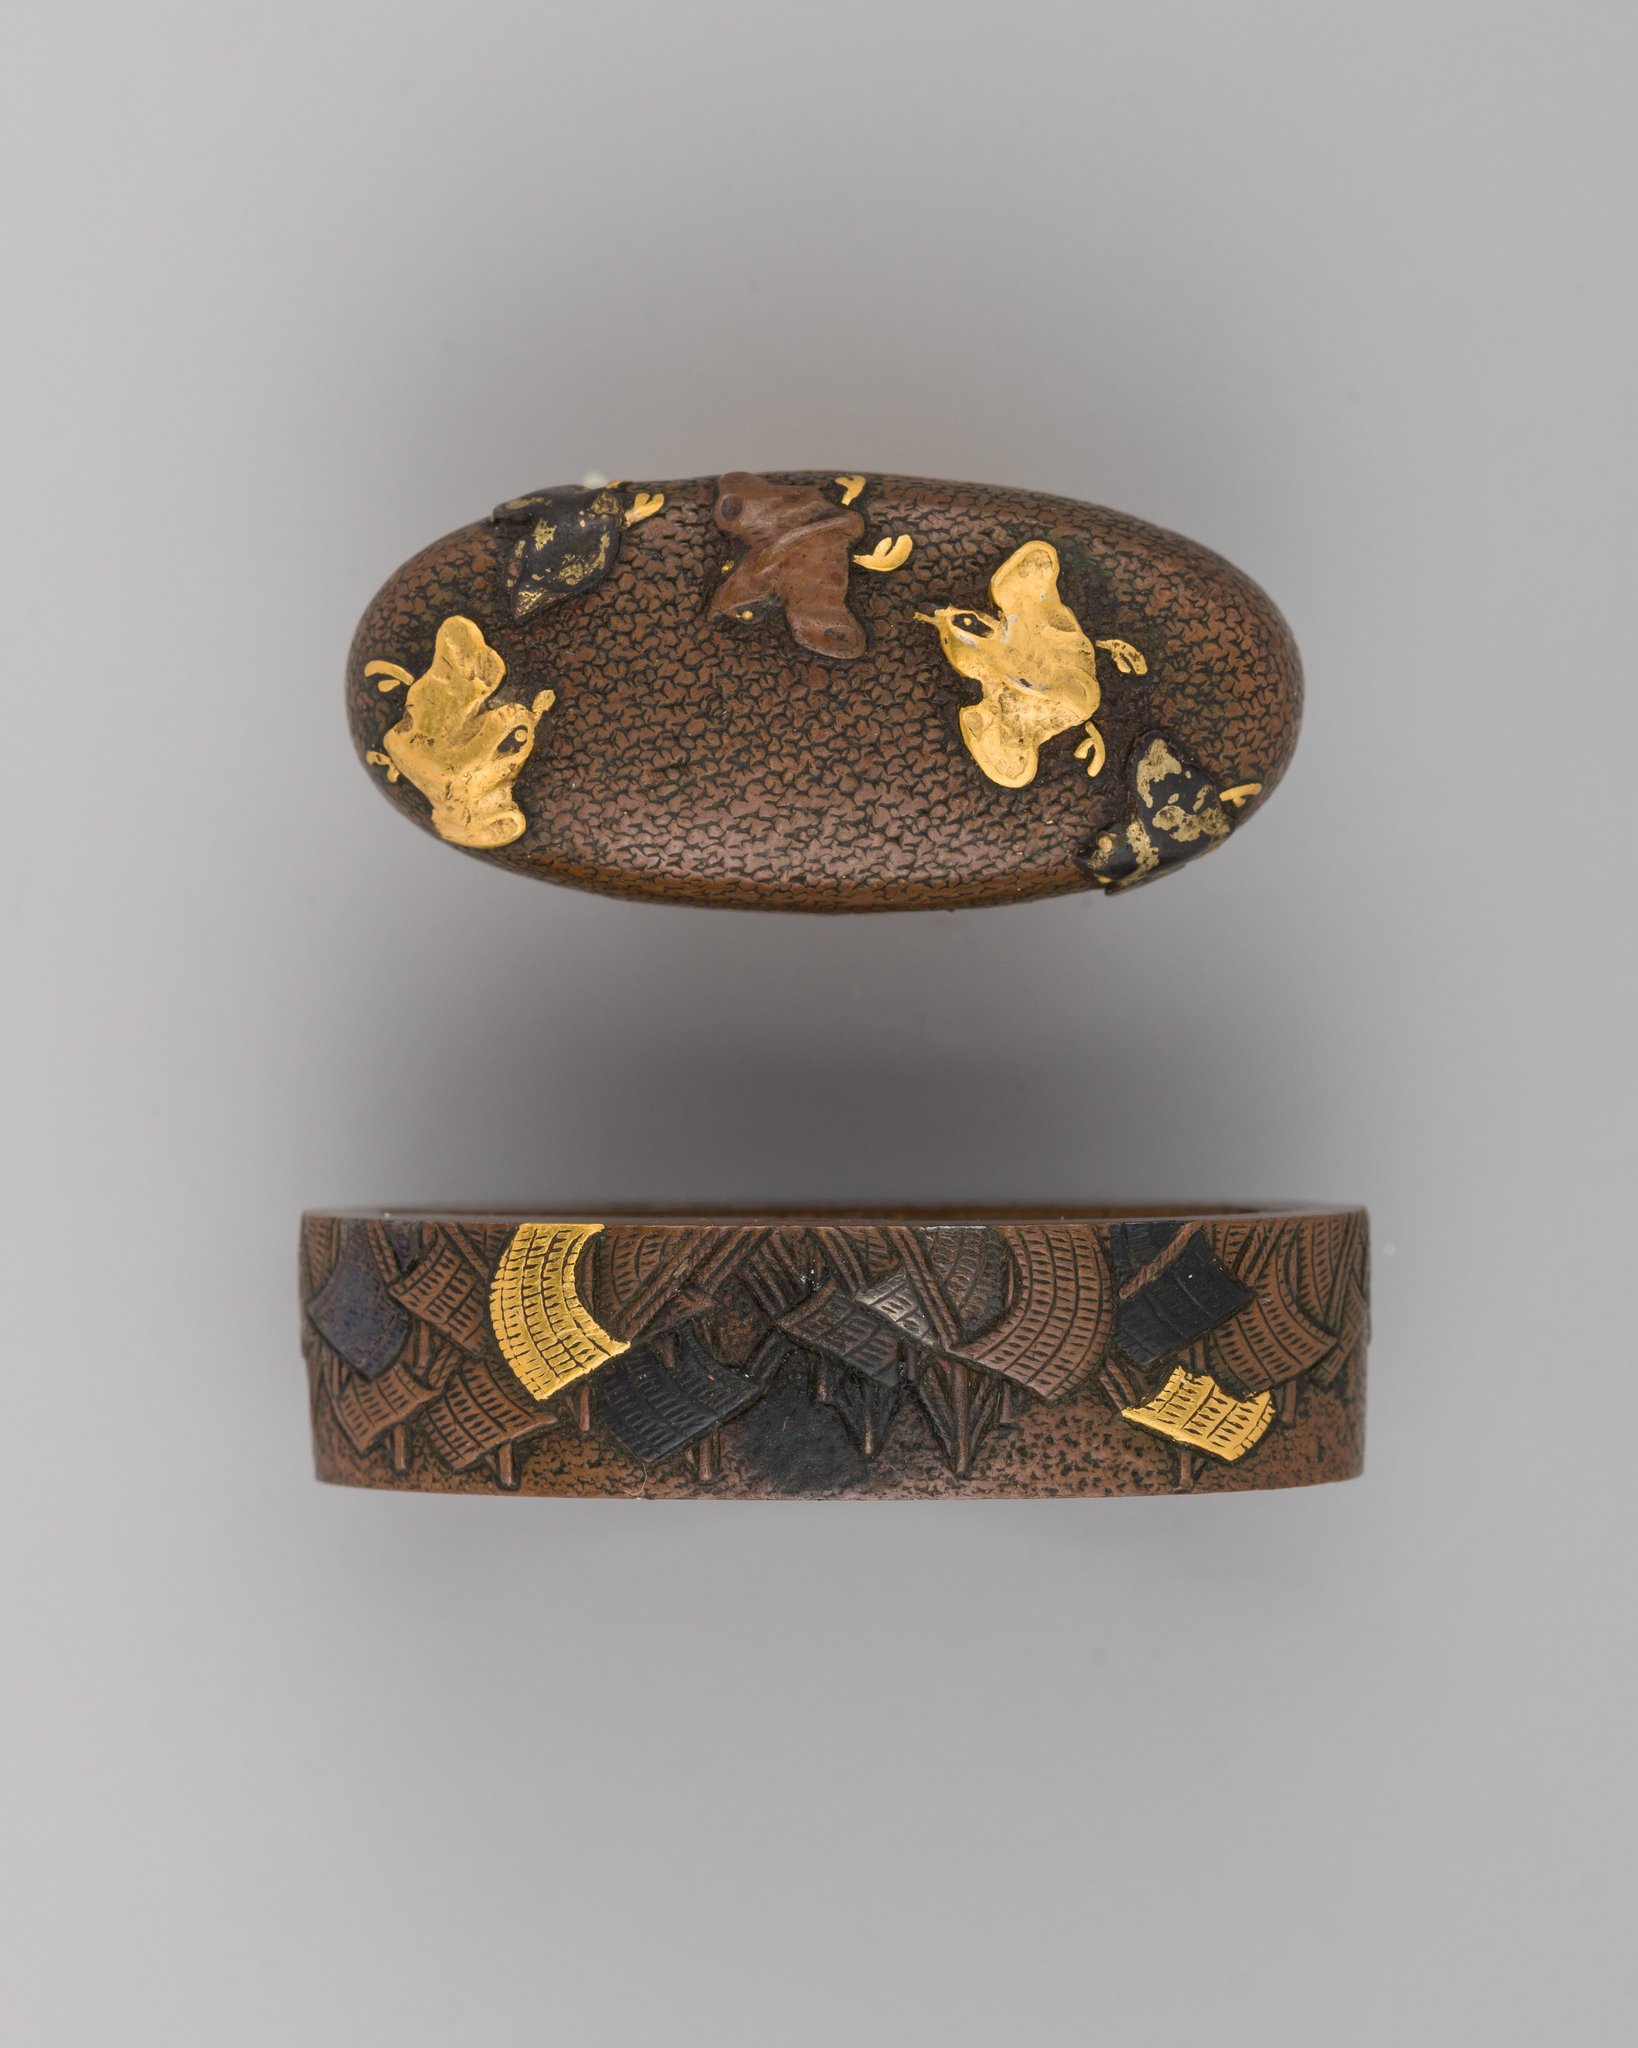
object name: sword hilt collar and pommel fuchigashira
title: Sword-Hilt Collar and Pommel (Fuchigashira)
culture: japanese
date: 1701-1800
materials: copper, gold alloy, silver alloy, gold, silver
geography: japan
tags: birds